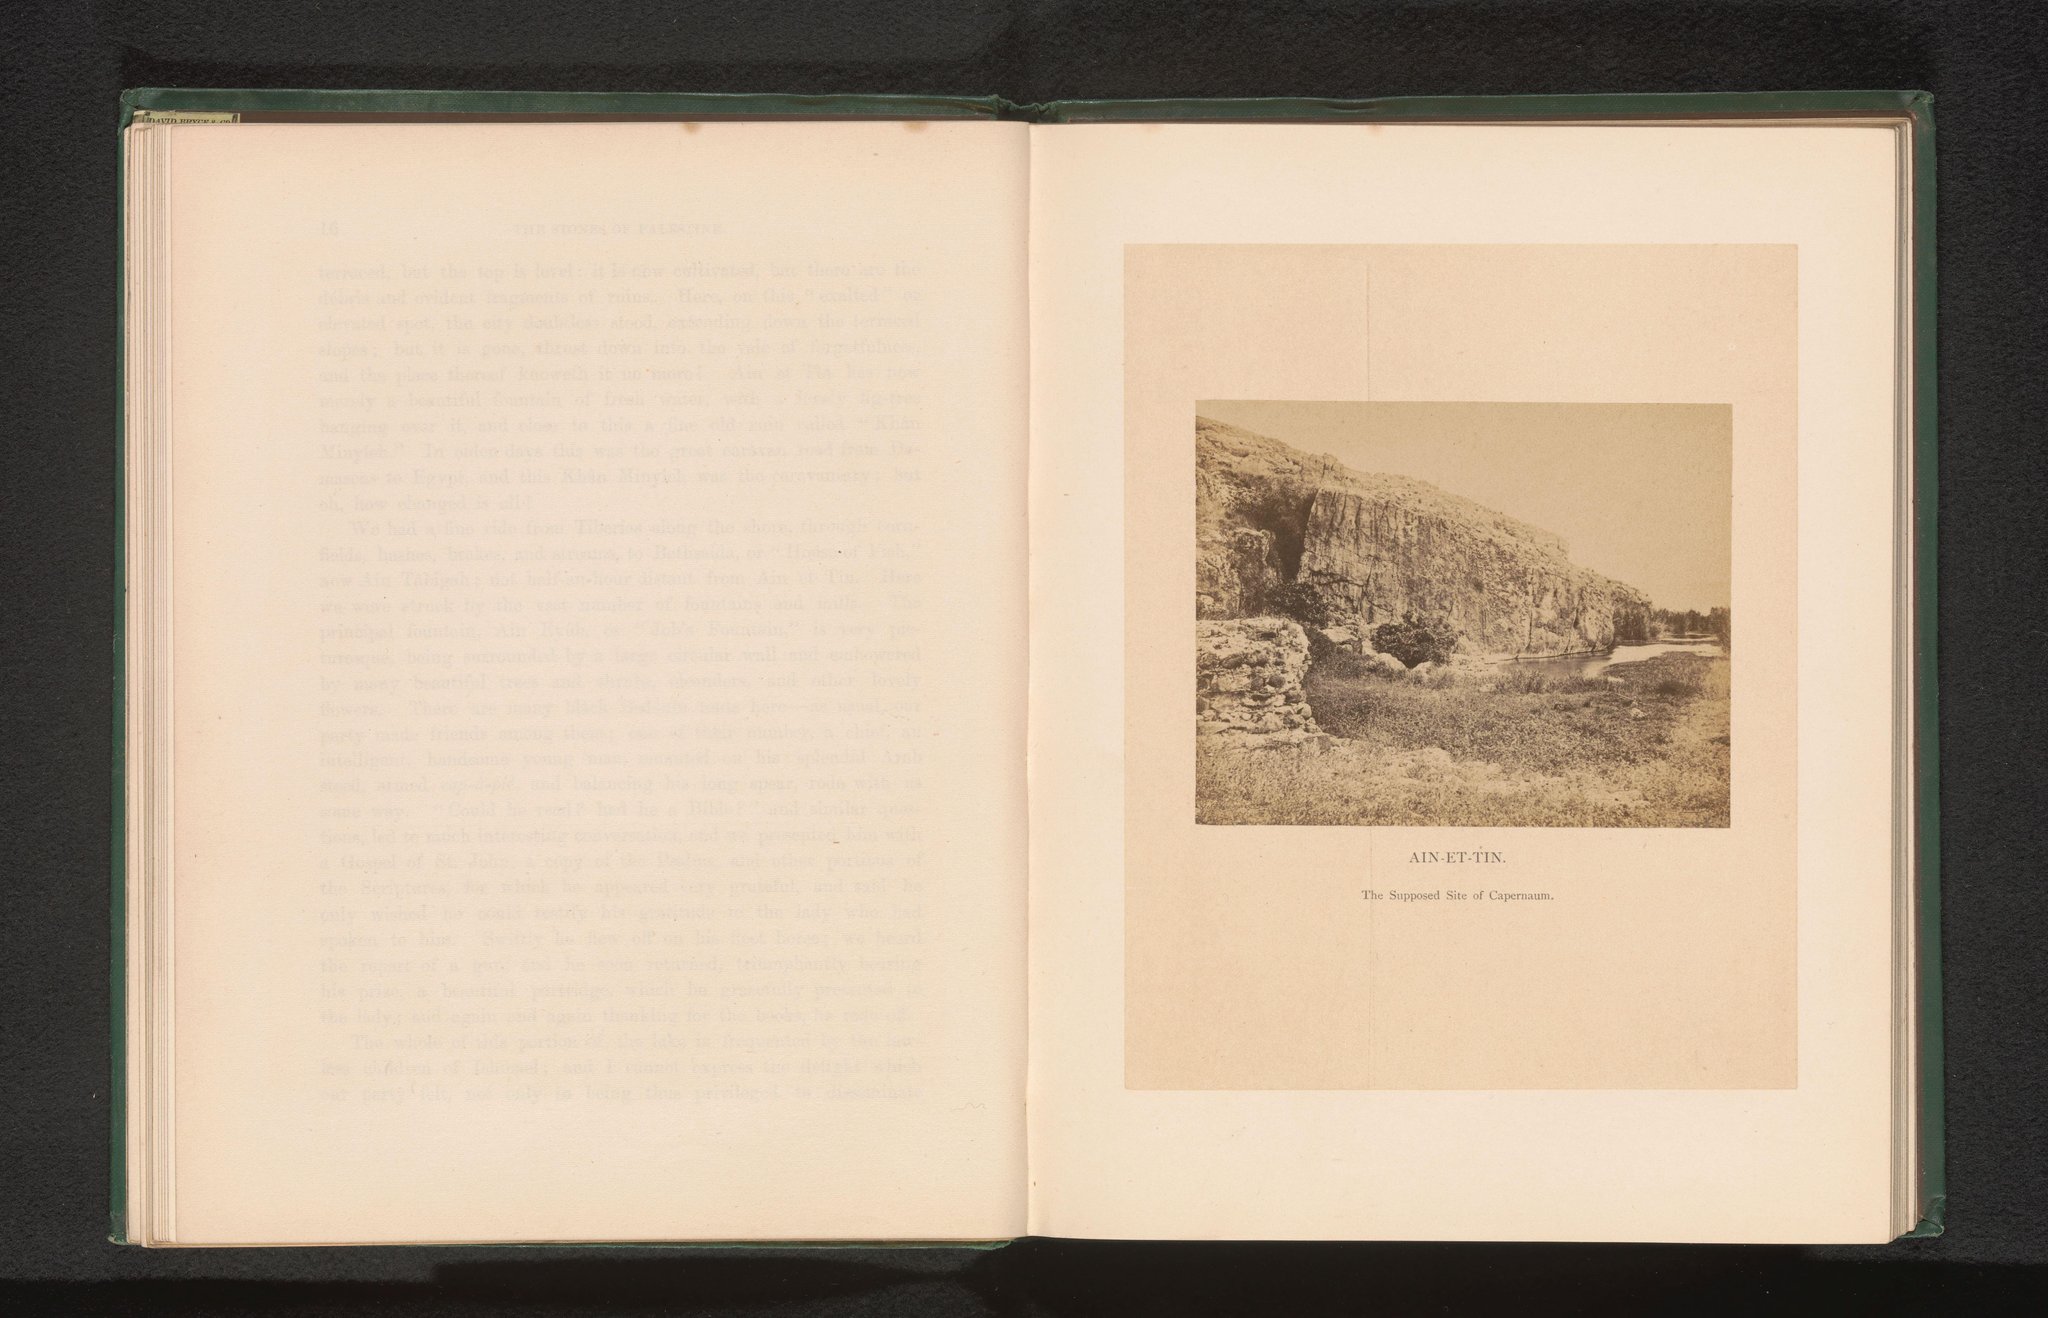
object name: page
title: Ain-et-Tin. The supposed site of Capernaum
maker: francis bedford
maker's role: print maker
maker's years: 1815-1894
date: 1860-1865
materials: photographic support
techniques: albumen print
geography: palestine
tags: landscape with ruins